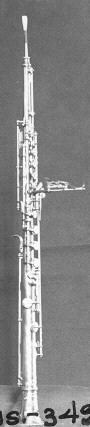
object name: tenor sarrusophone in b flat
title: Soprano Sarrusophone in B-flat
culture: french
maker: gautrot-marquet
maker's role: maker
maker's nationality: french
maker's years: 1875-1884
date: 1867-1900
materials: brass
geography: france